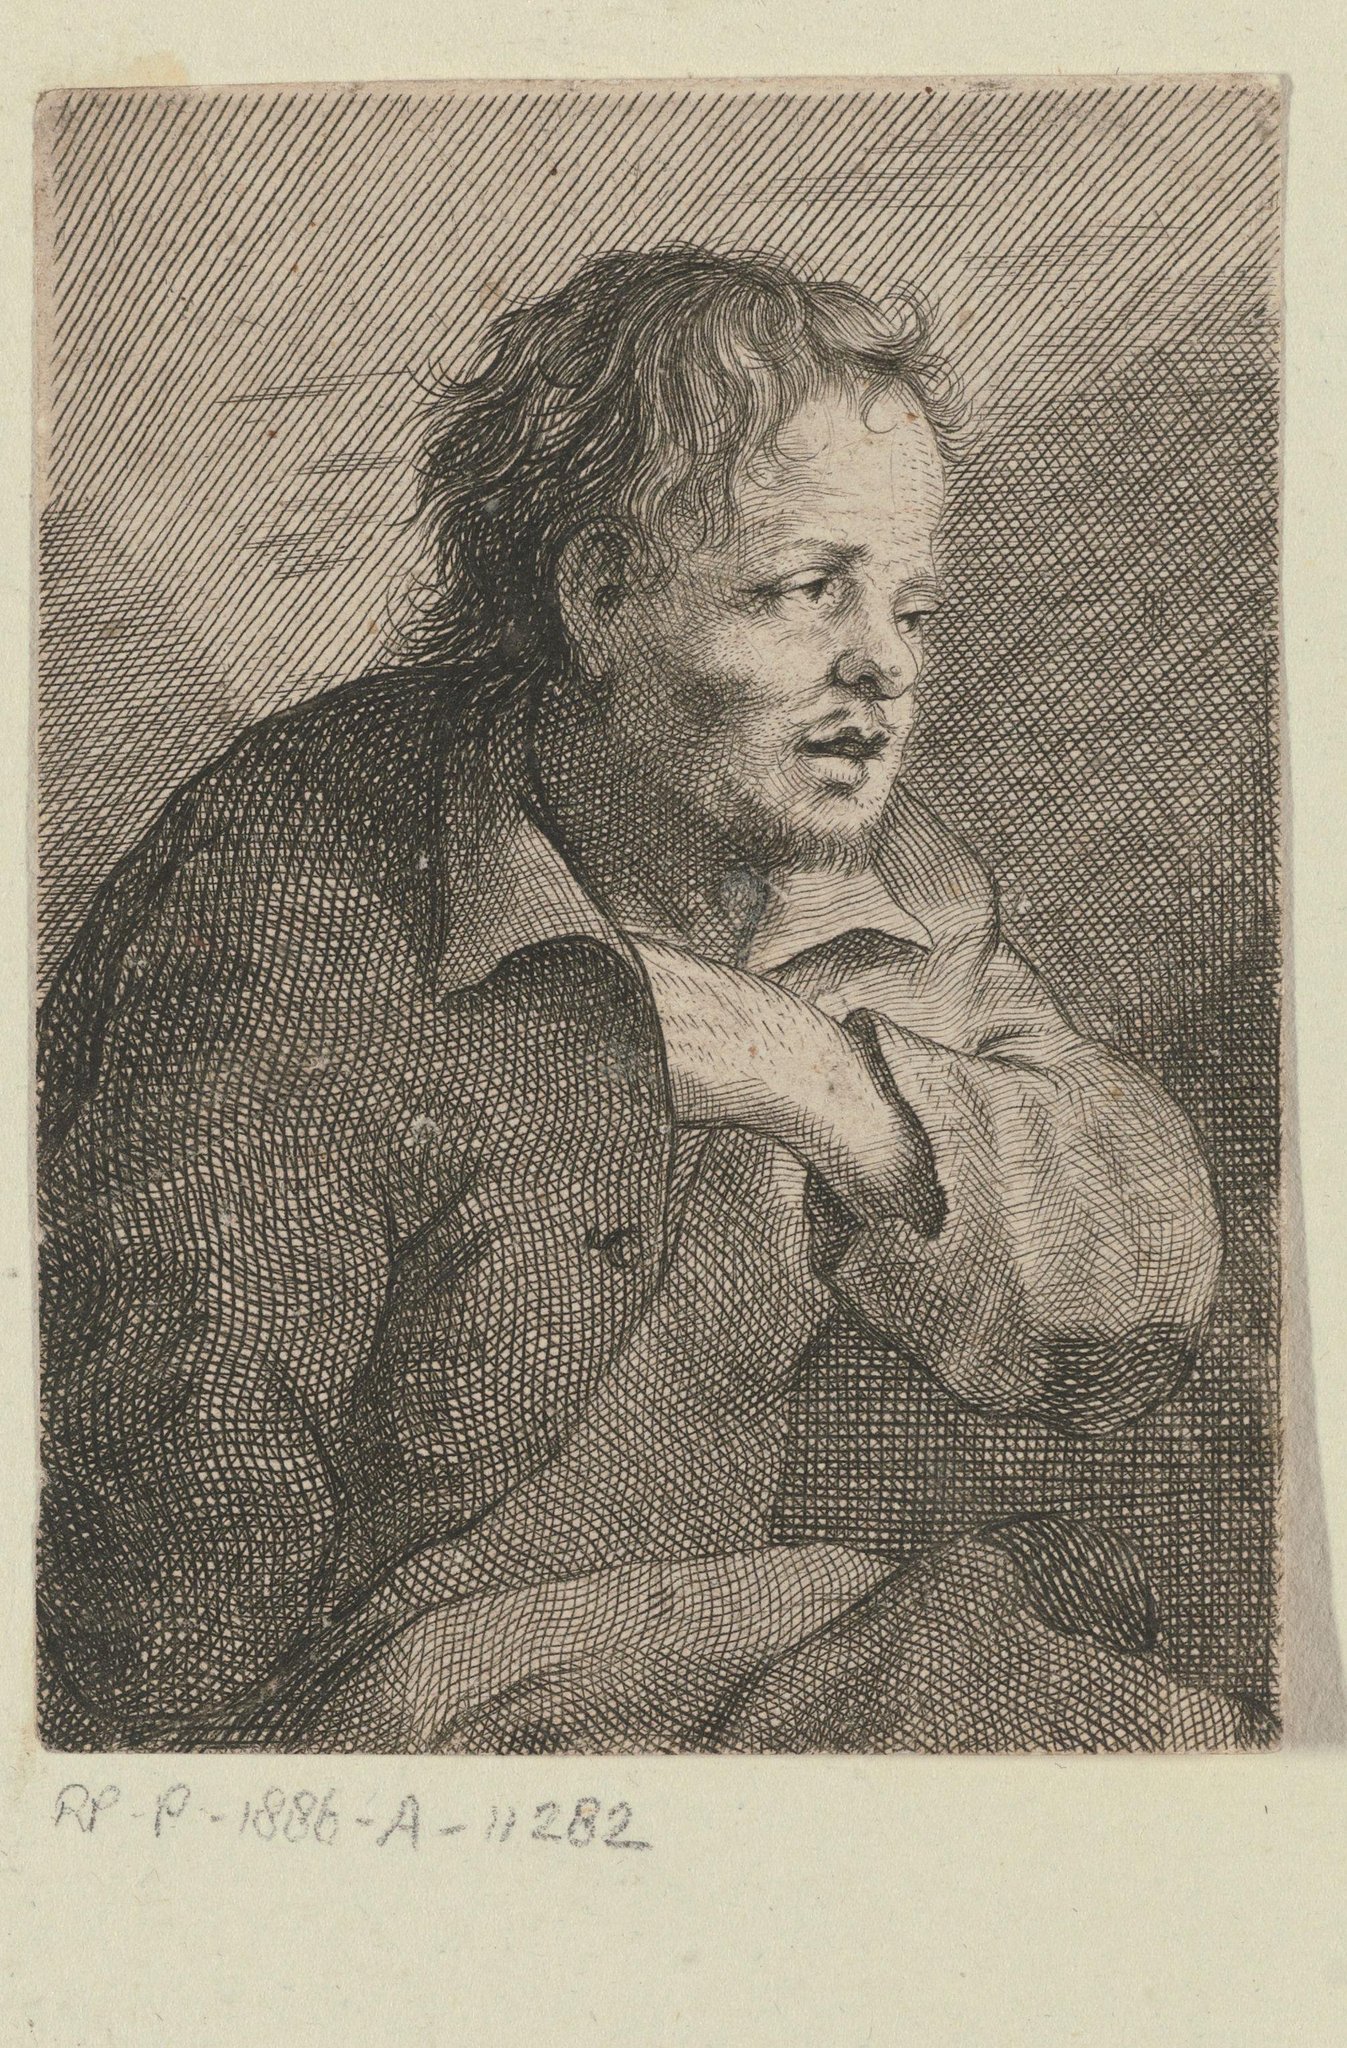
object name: print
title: Man met een hand in zijn jas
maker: Anonymous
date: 1600-1800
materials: paper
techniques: engraving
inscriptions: collector's mark: Lugt 2228